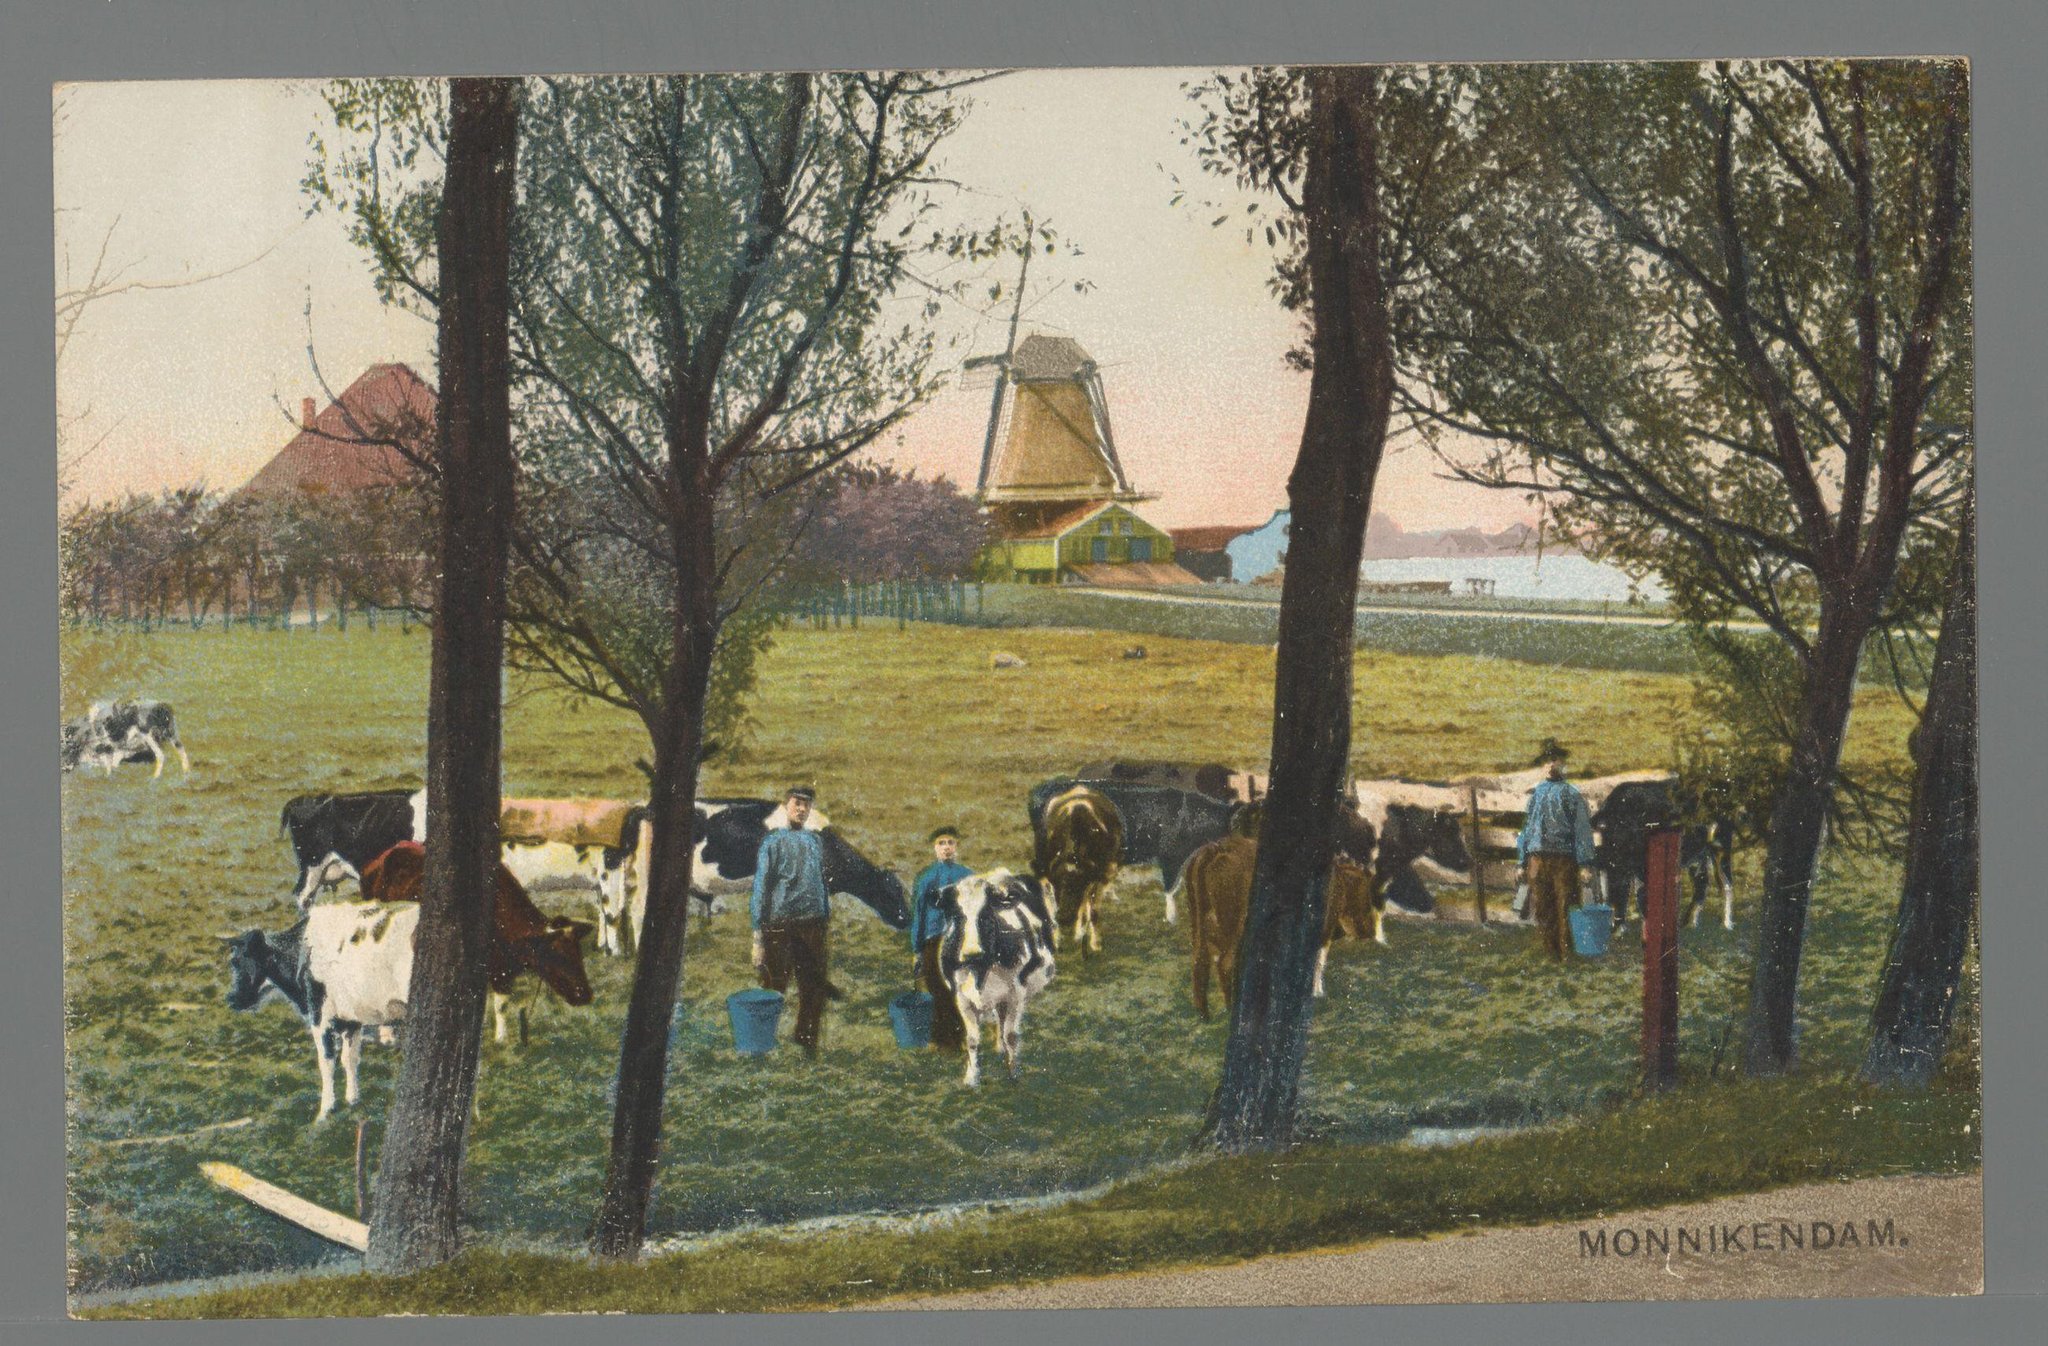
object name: ansichtkaart, prentbriefkaart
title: Monnikendam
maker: Anonymous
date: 1906-1945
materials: cardboard, photographic process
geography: dresden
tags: windmill in landscape, bovine cattle